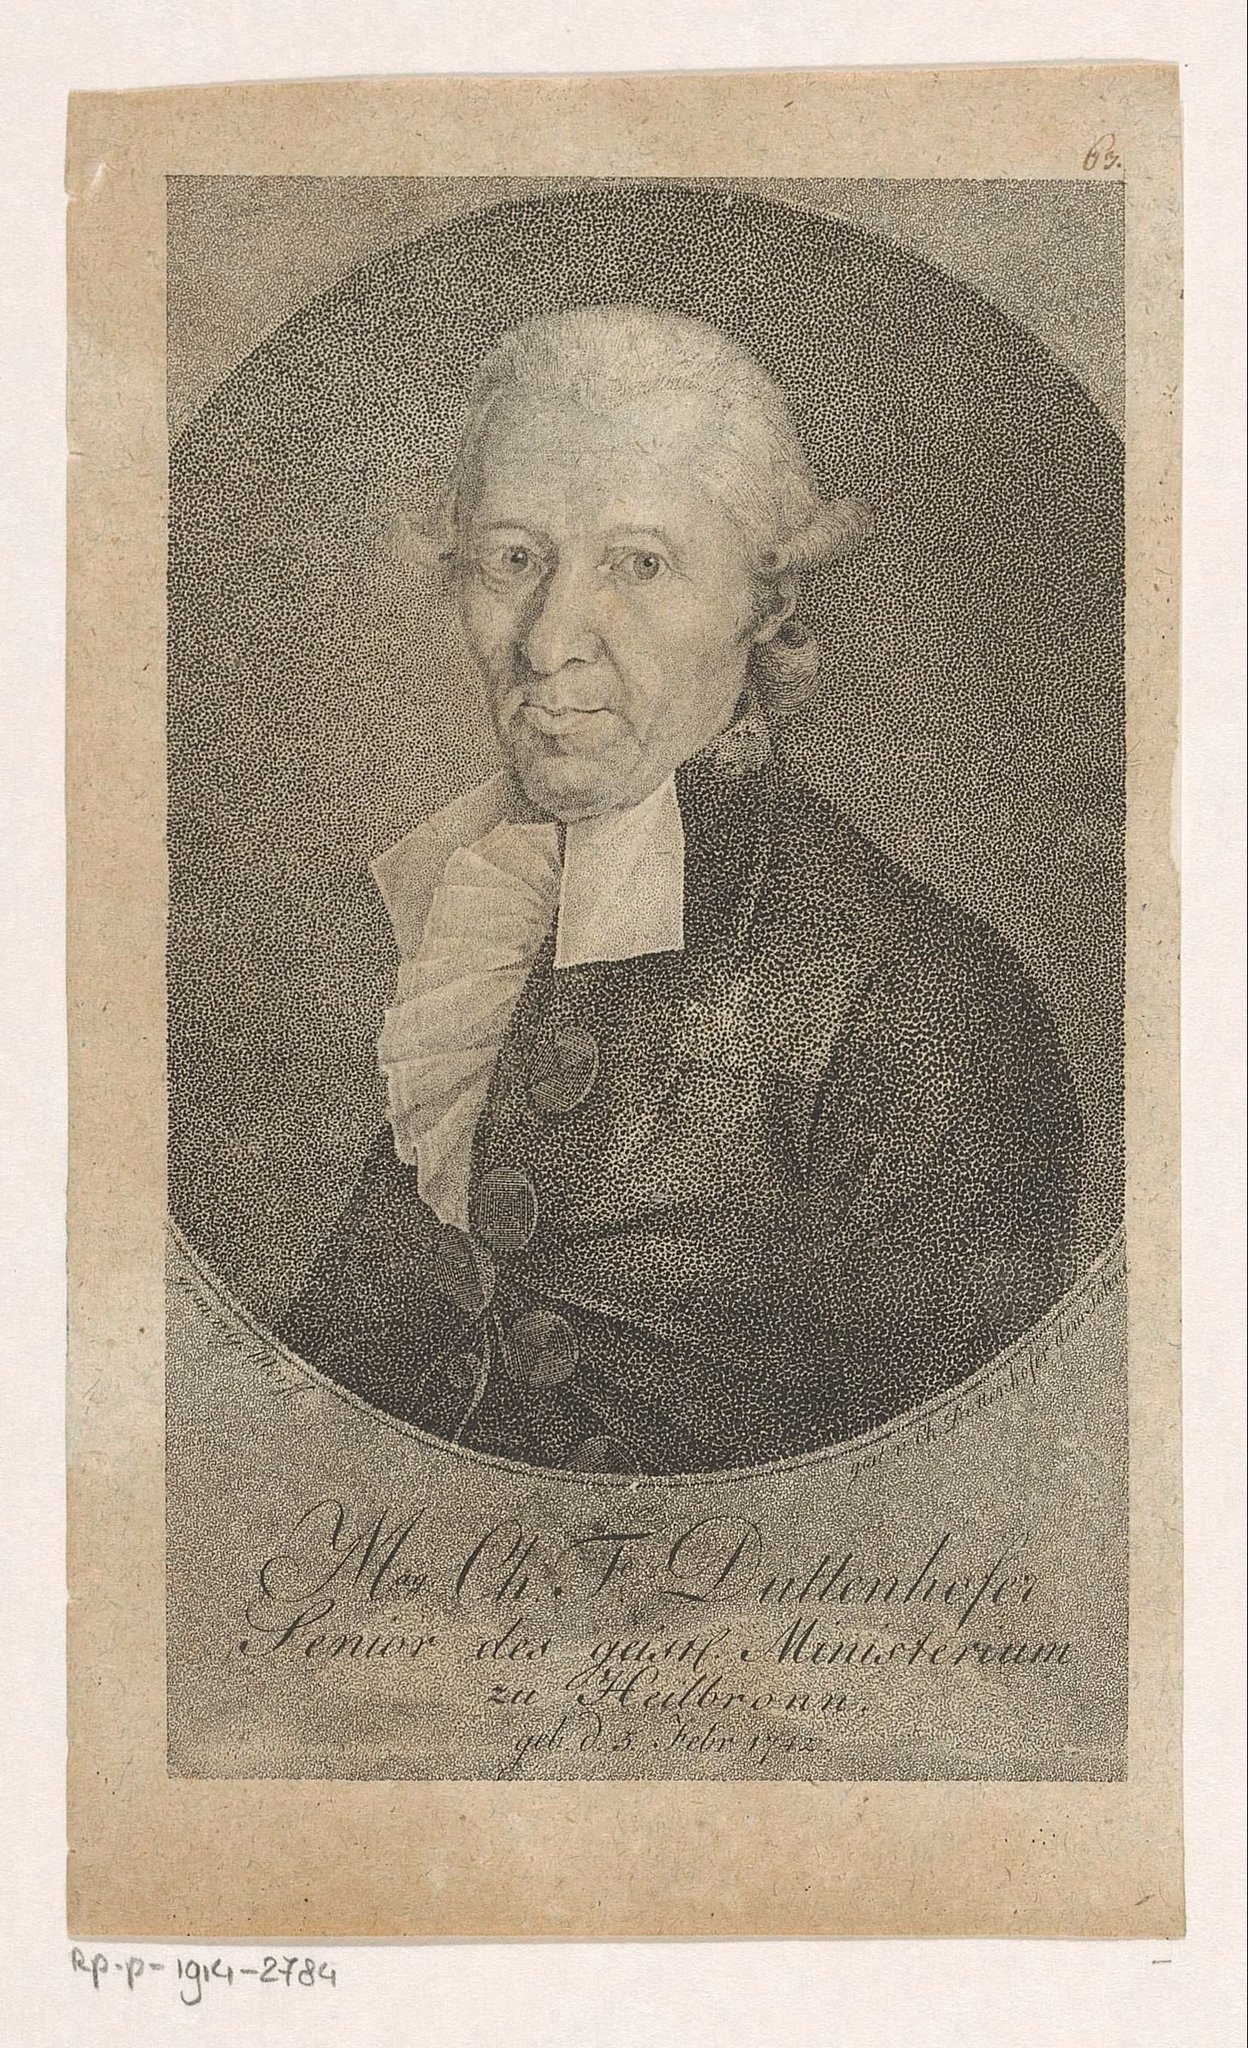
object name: print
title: Portret van Christian Friedrich Duttenhofer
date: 1788-1814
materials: paper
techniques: stippling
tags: historical persons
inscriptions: collector's mark: Lugt 2228